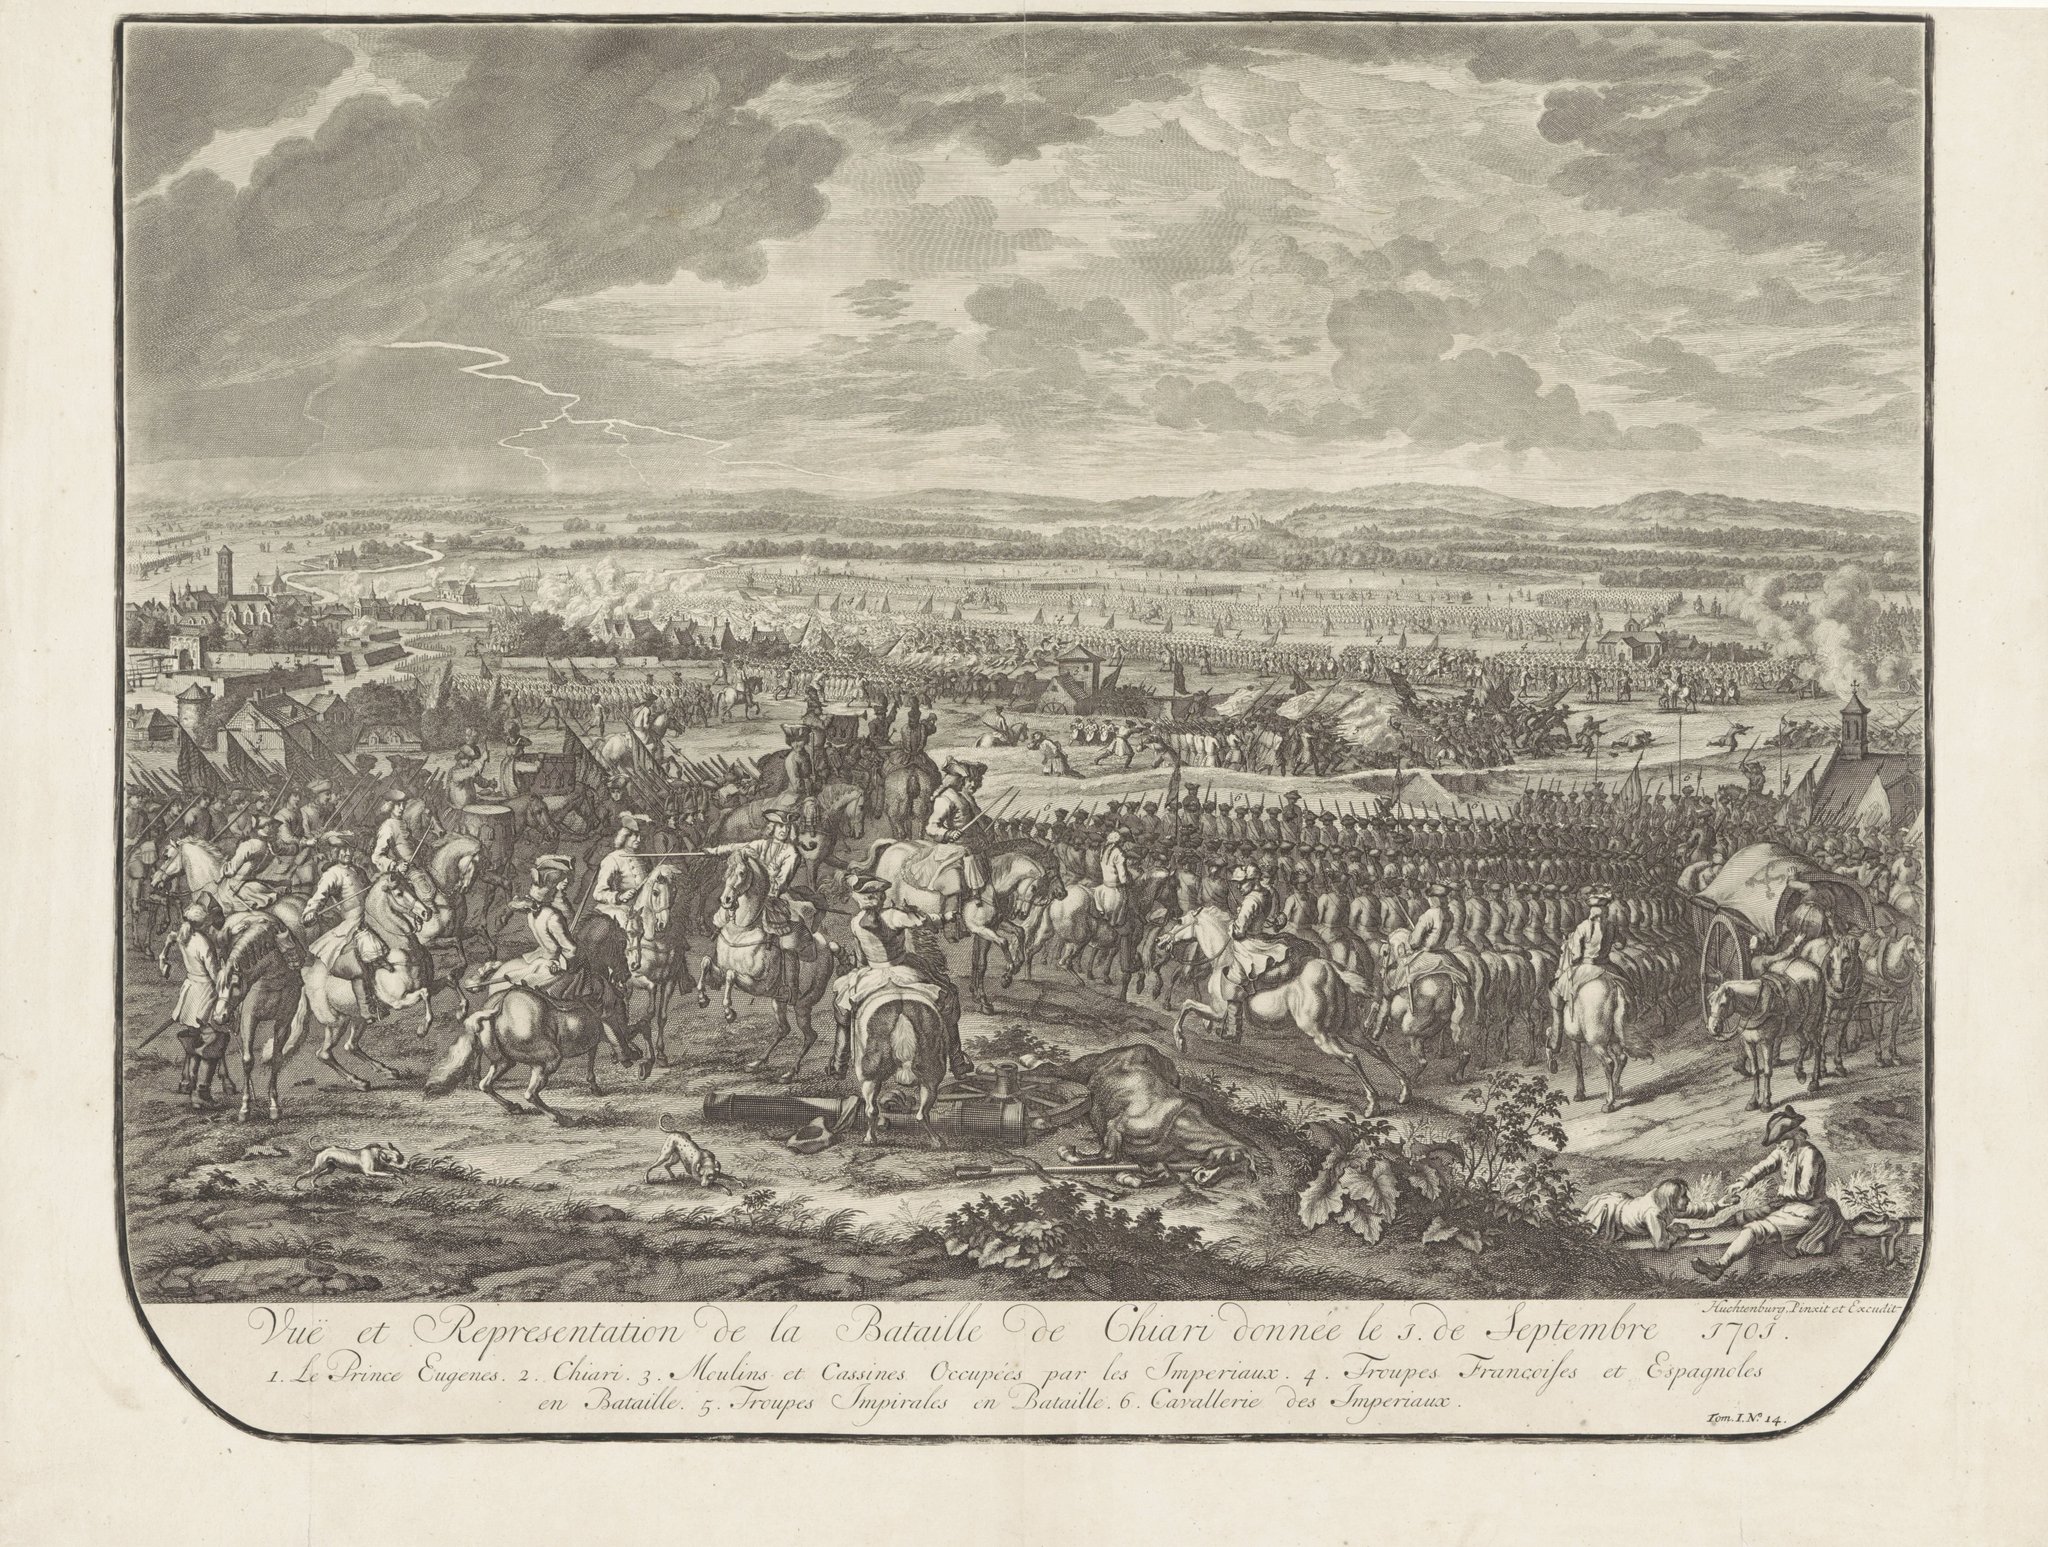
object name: print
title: Vuë et representation de la bataille de Chiari donnée le 1. de Septembre 1701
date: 1729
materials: paper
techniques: engraving, etching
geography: the hague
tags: paris, eugenius van savoye, battle (+ land forces)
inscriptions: collector's mark: Lugt 2228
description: Prent mogelijk gebruikt in: Jean Du Mont baron de Carels-Croon, Oorlogskundige beschryving van de veldslagen (...) der drie (...) krygsoversten (...) den prins Eugenius van Savoye, den prins en hertog van Marlborough, en den prins van Oranje- en Nassau-Vriesland, 's-Gravenhage: Isaac van der Kloot, 1729. Deel 1, nr. 14.